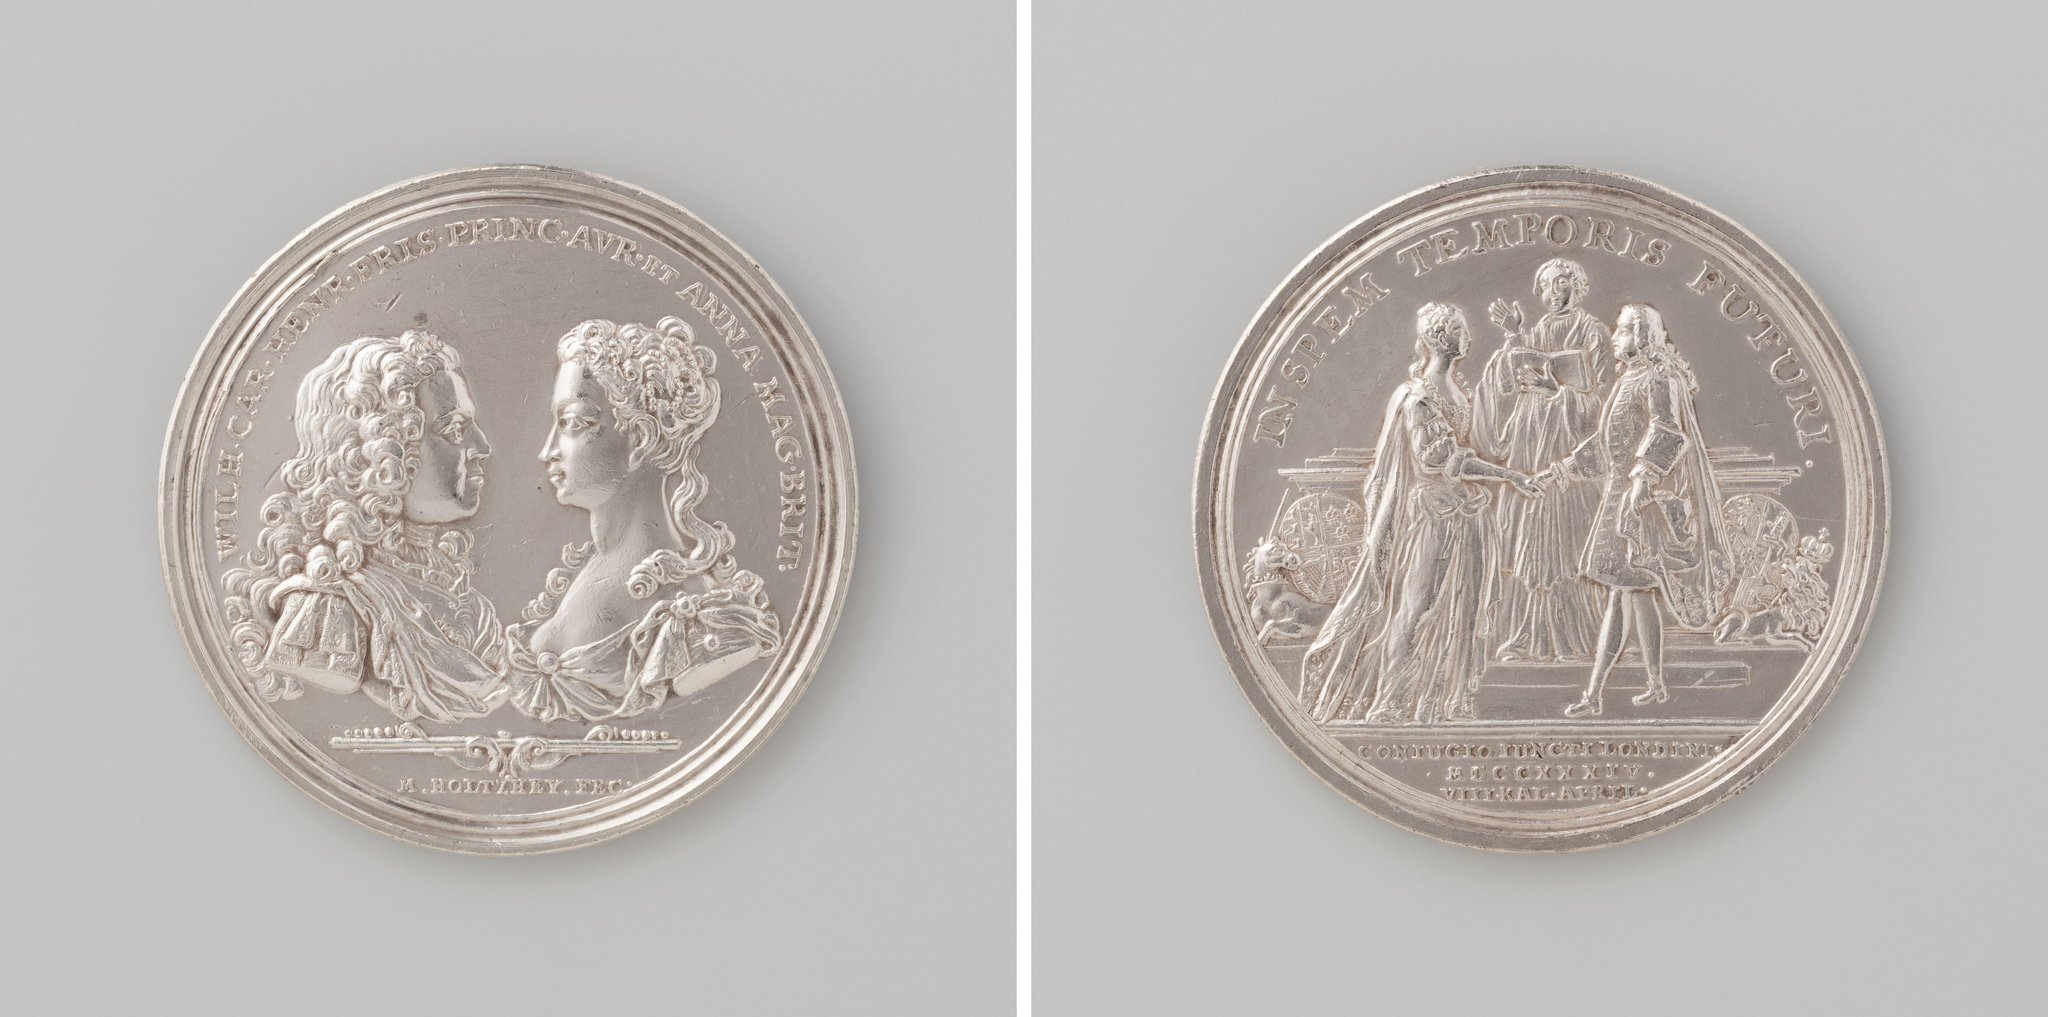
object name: history medal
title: Huwelijk van Willem IV met prinses Anna van Engeland te Londen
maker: martinus holtzhey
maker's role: medailleur, muntmaker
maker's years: 1697-1764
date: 1734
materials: silver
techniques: striking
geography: amsterdam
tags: willem iv (prins van oranje-nassau), the hague, anna van hannover, london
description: Zilveren penning. Voorzijde: naar elkaar gewende borststukken van man en vrouw binnen omschrift. Keerzijde: bisschop leest uit boek, staande voor altaar, voor hem prins en prinses die elkaar hand reiken, links eenhoorn met wapenschild, rechts gekroonde leeuw met wapenschild binnen omschrift; afsnede: jaartal.